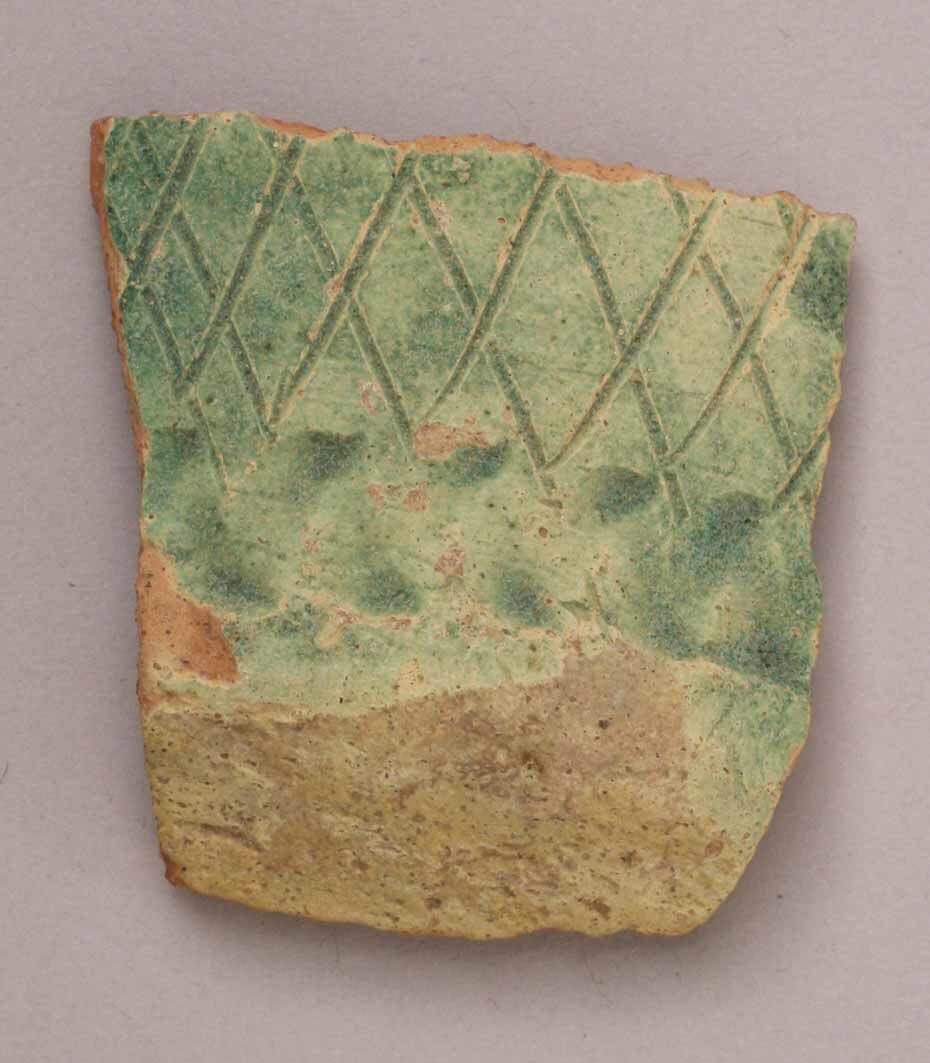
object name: fragment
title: Ceramic Fragment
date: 1001-1100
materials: earthenware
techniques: glazing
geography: saudi arabia